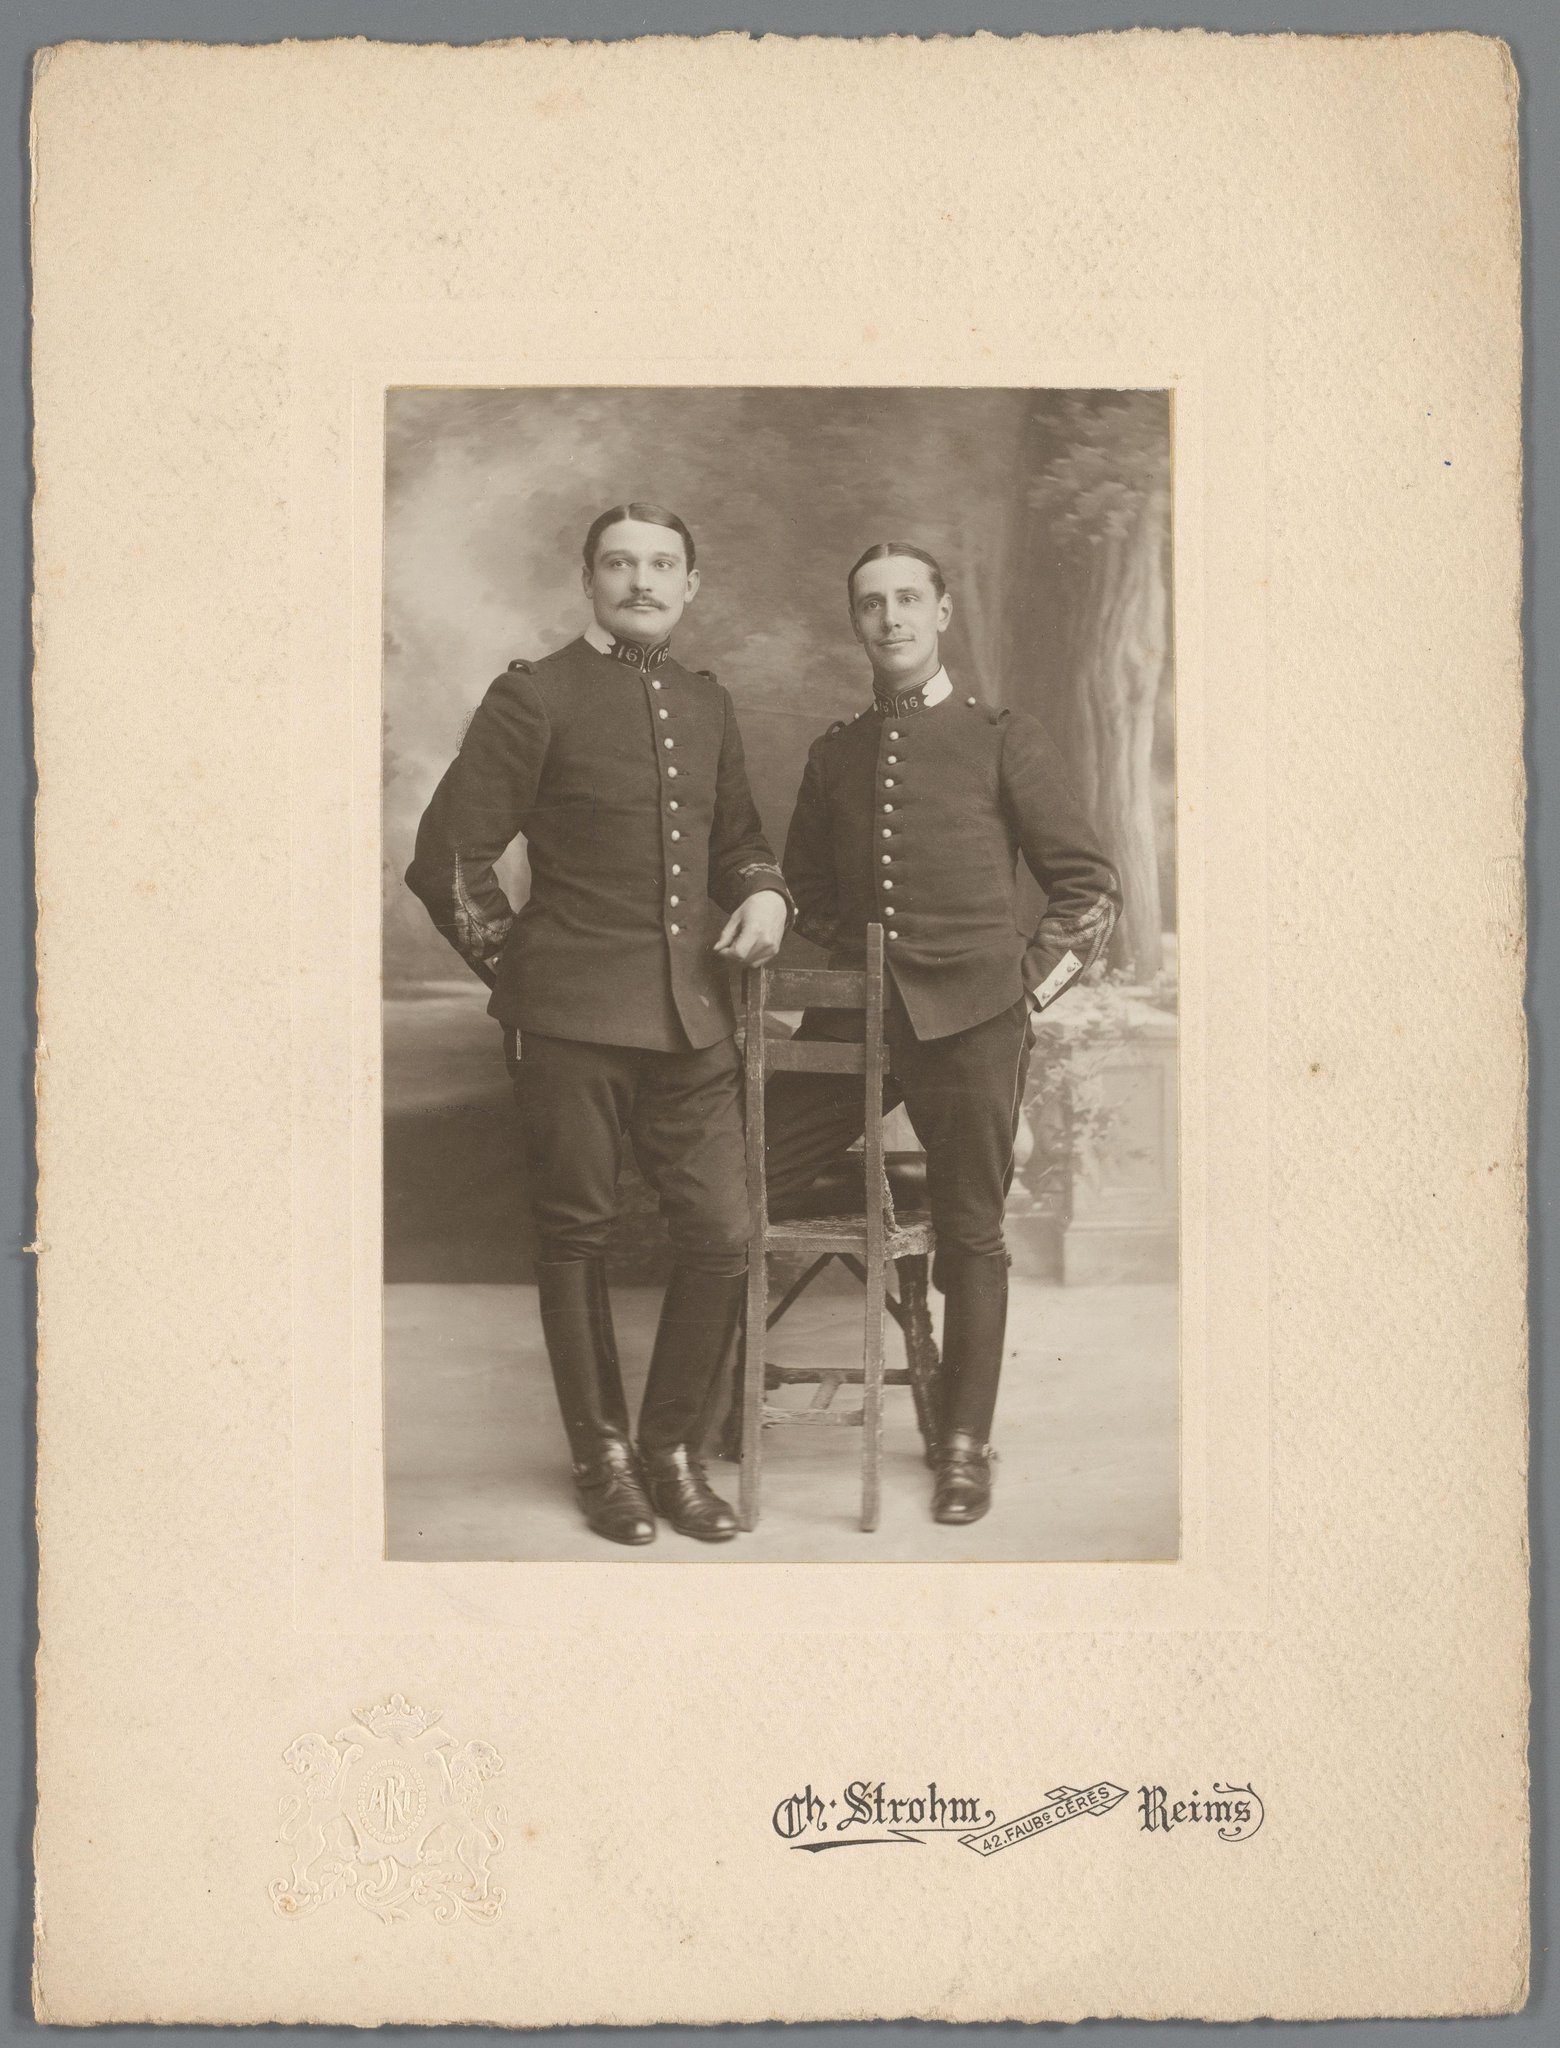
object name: photograph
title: Portret van twee onbekende mannen in uniform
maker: ch. strohm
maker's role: fotograaf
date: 1880-1920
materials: cardboard, photographic support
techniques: daylight paper print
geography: reims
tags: adult man (+ two persons), anonymous historical persons portrayed in a double portrait, (military) uniforms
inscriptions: address: ‘CH. Strohn 42. FAUBG CÉRÈS REIMS’, check stamp: ‘ART’